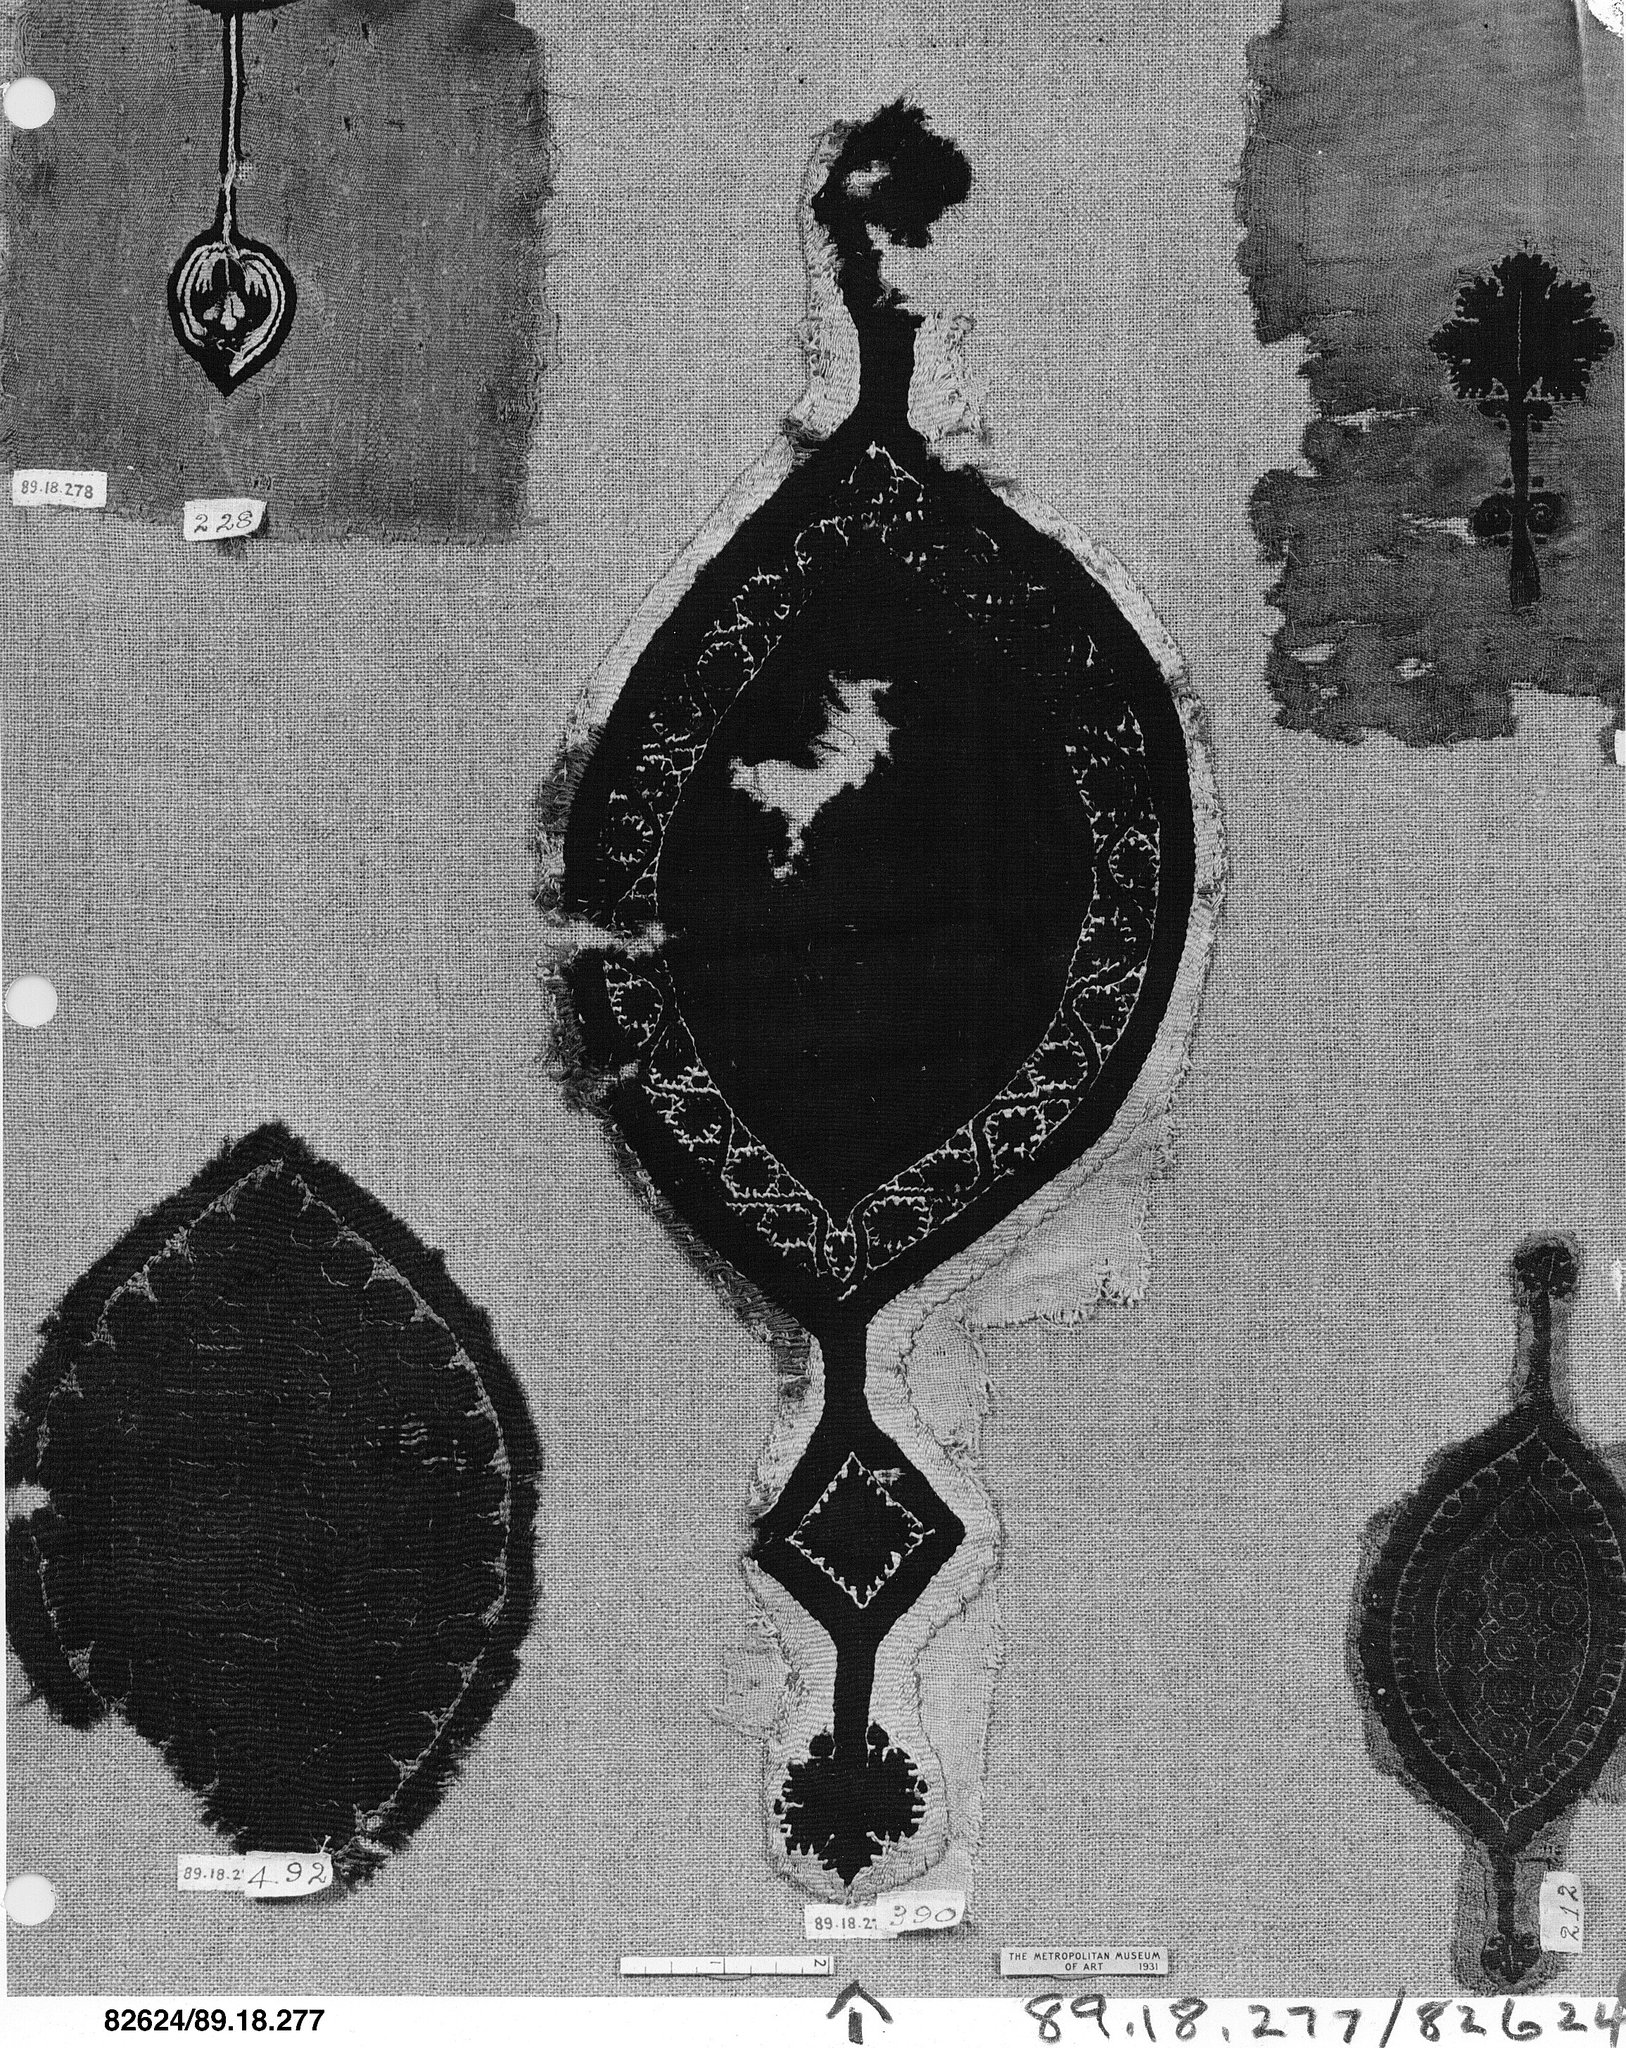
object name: textile fragment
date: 201-400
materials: linen, wool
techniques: weave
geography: egypt